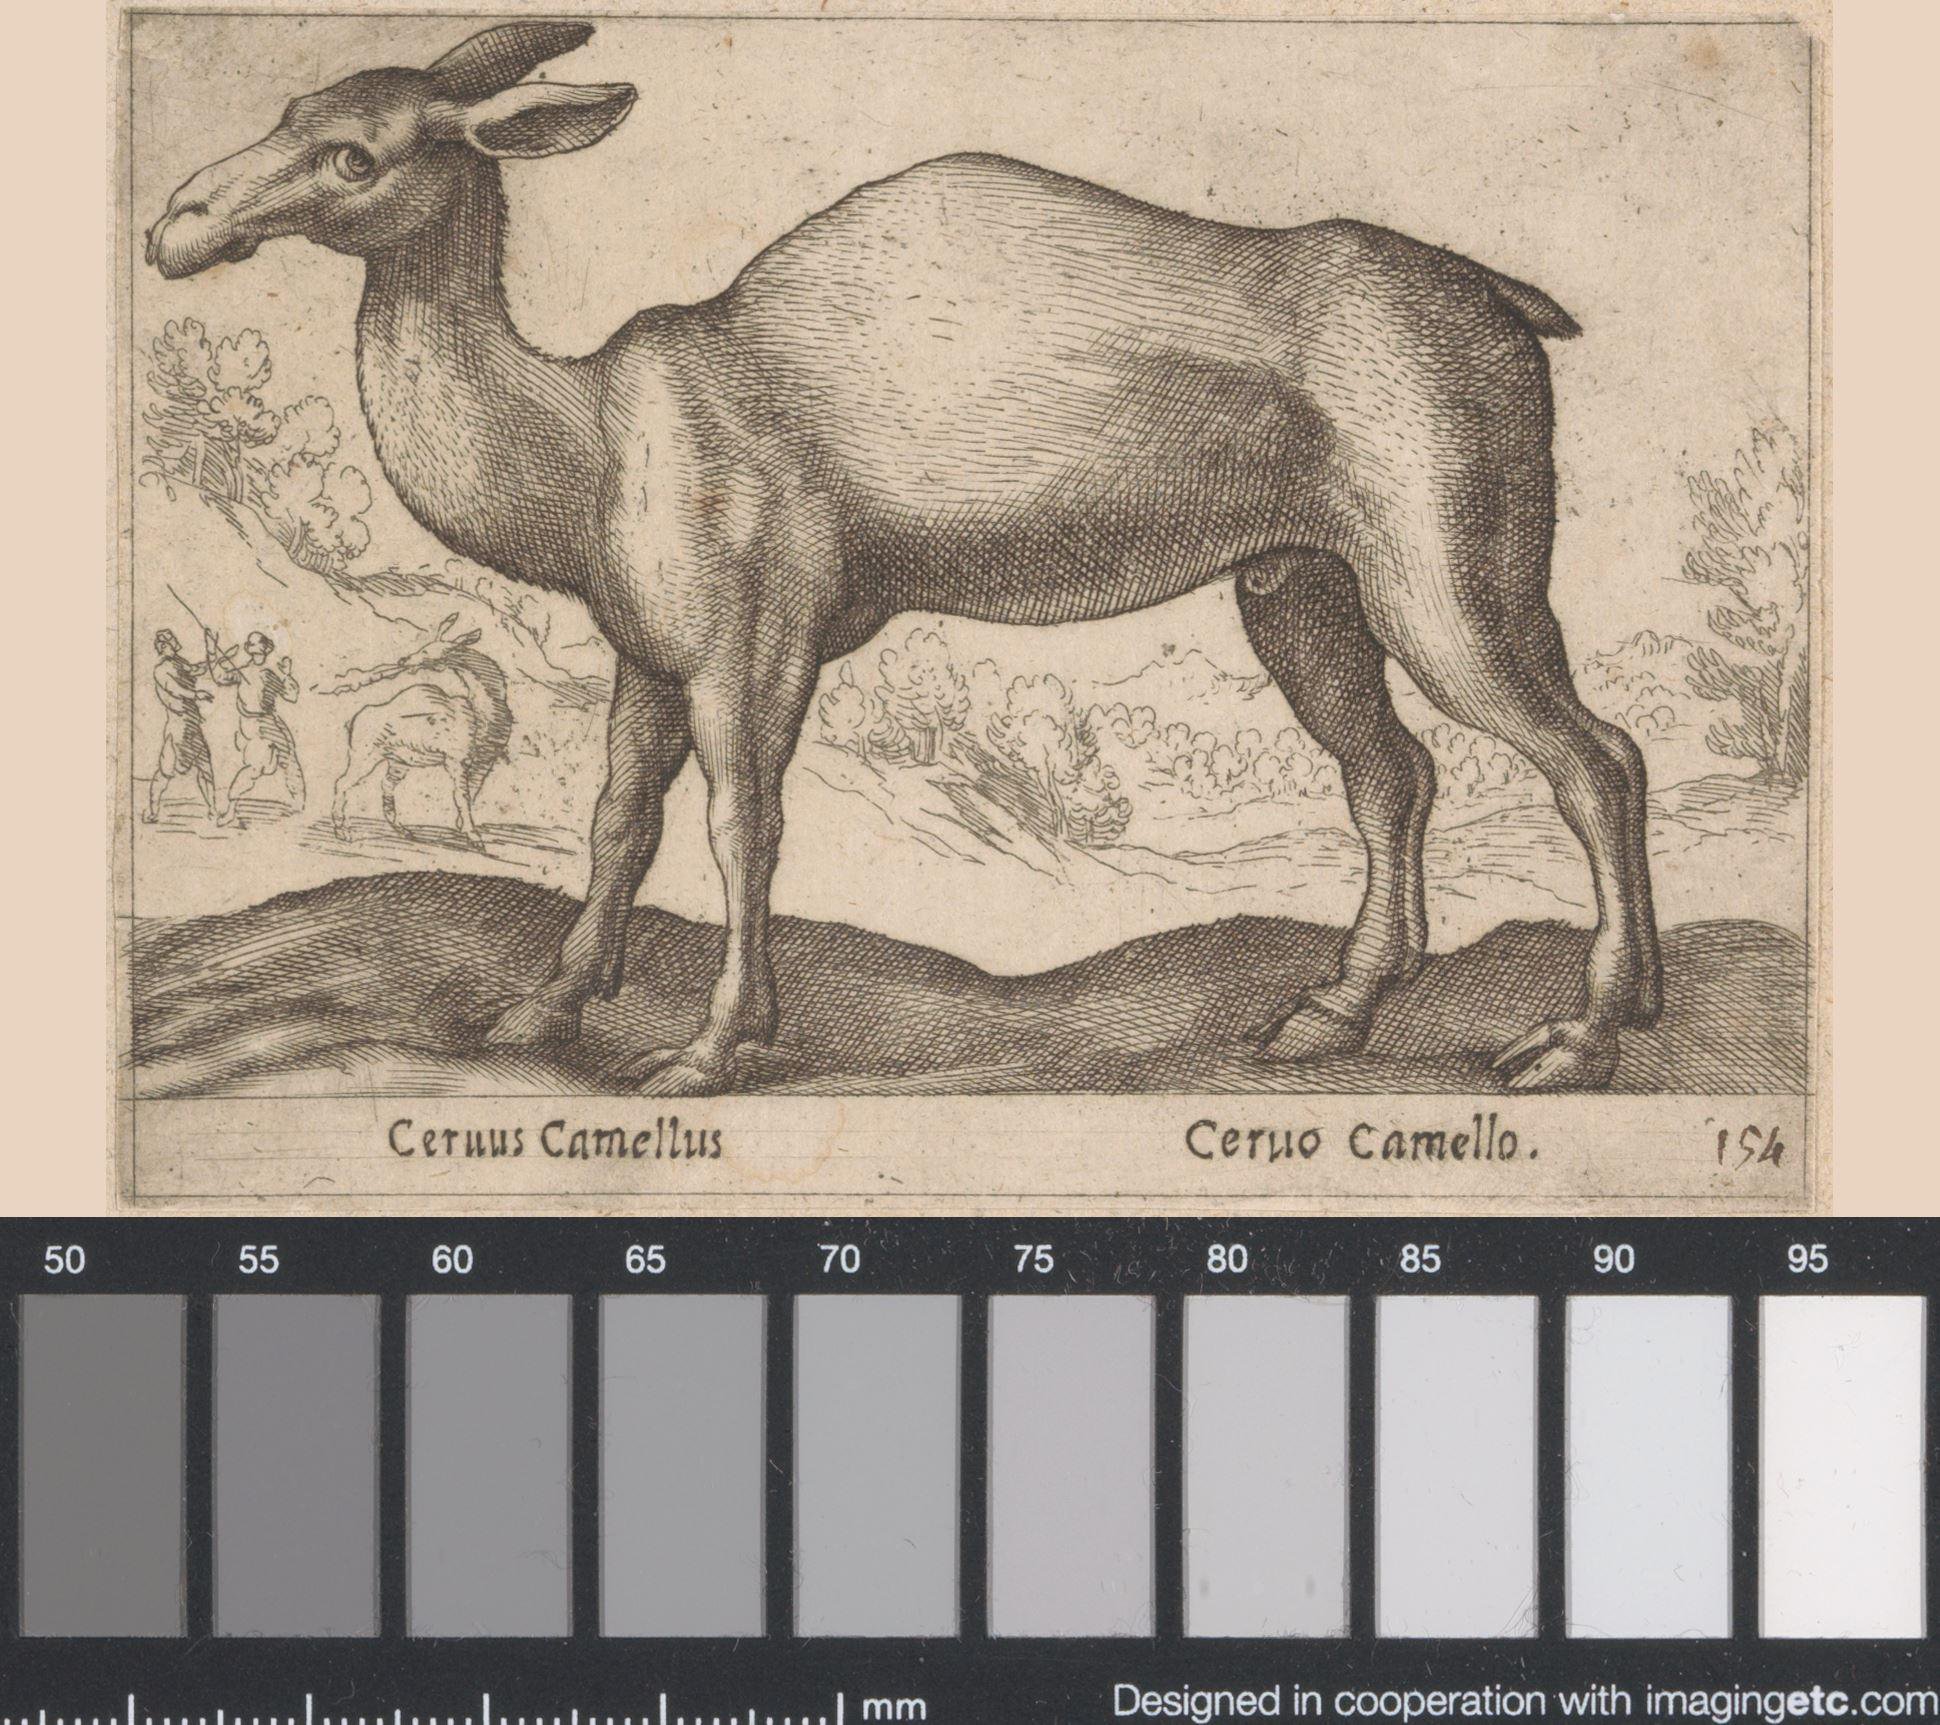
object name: print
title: Ceruus Camellus/ Cervo Camello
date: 1565-1630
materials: paper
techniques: etching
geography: italy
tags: hoofed animals: camel, hoofed animals: deer, mis-shapen animals; monsters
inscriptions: number: ‘154’, collector's mark: Lugt 11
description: Deze prent maakt deel uit van een reeks prenten van dieren door Antonio Tempesta. Bekend is dat een tweede staat (met nummering) van deze serie is uitgegeven door Giovanni Giacomo de' Rossi in 1650. Onbekend is wie de eerste staat heeft uitgegeven en wanneer.